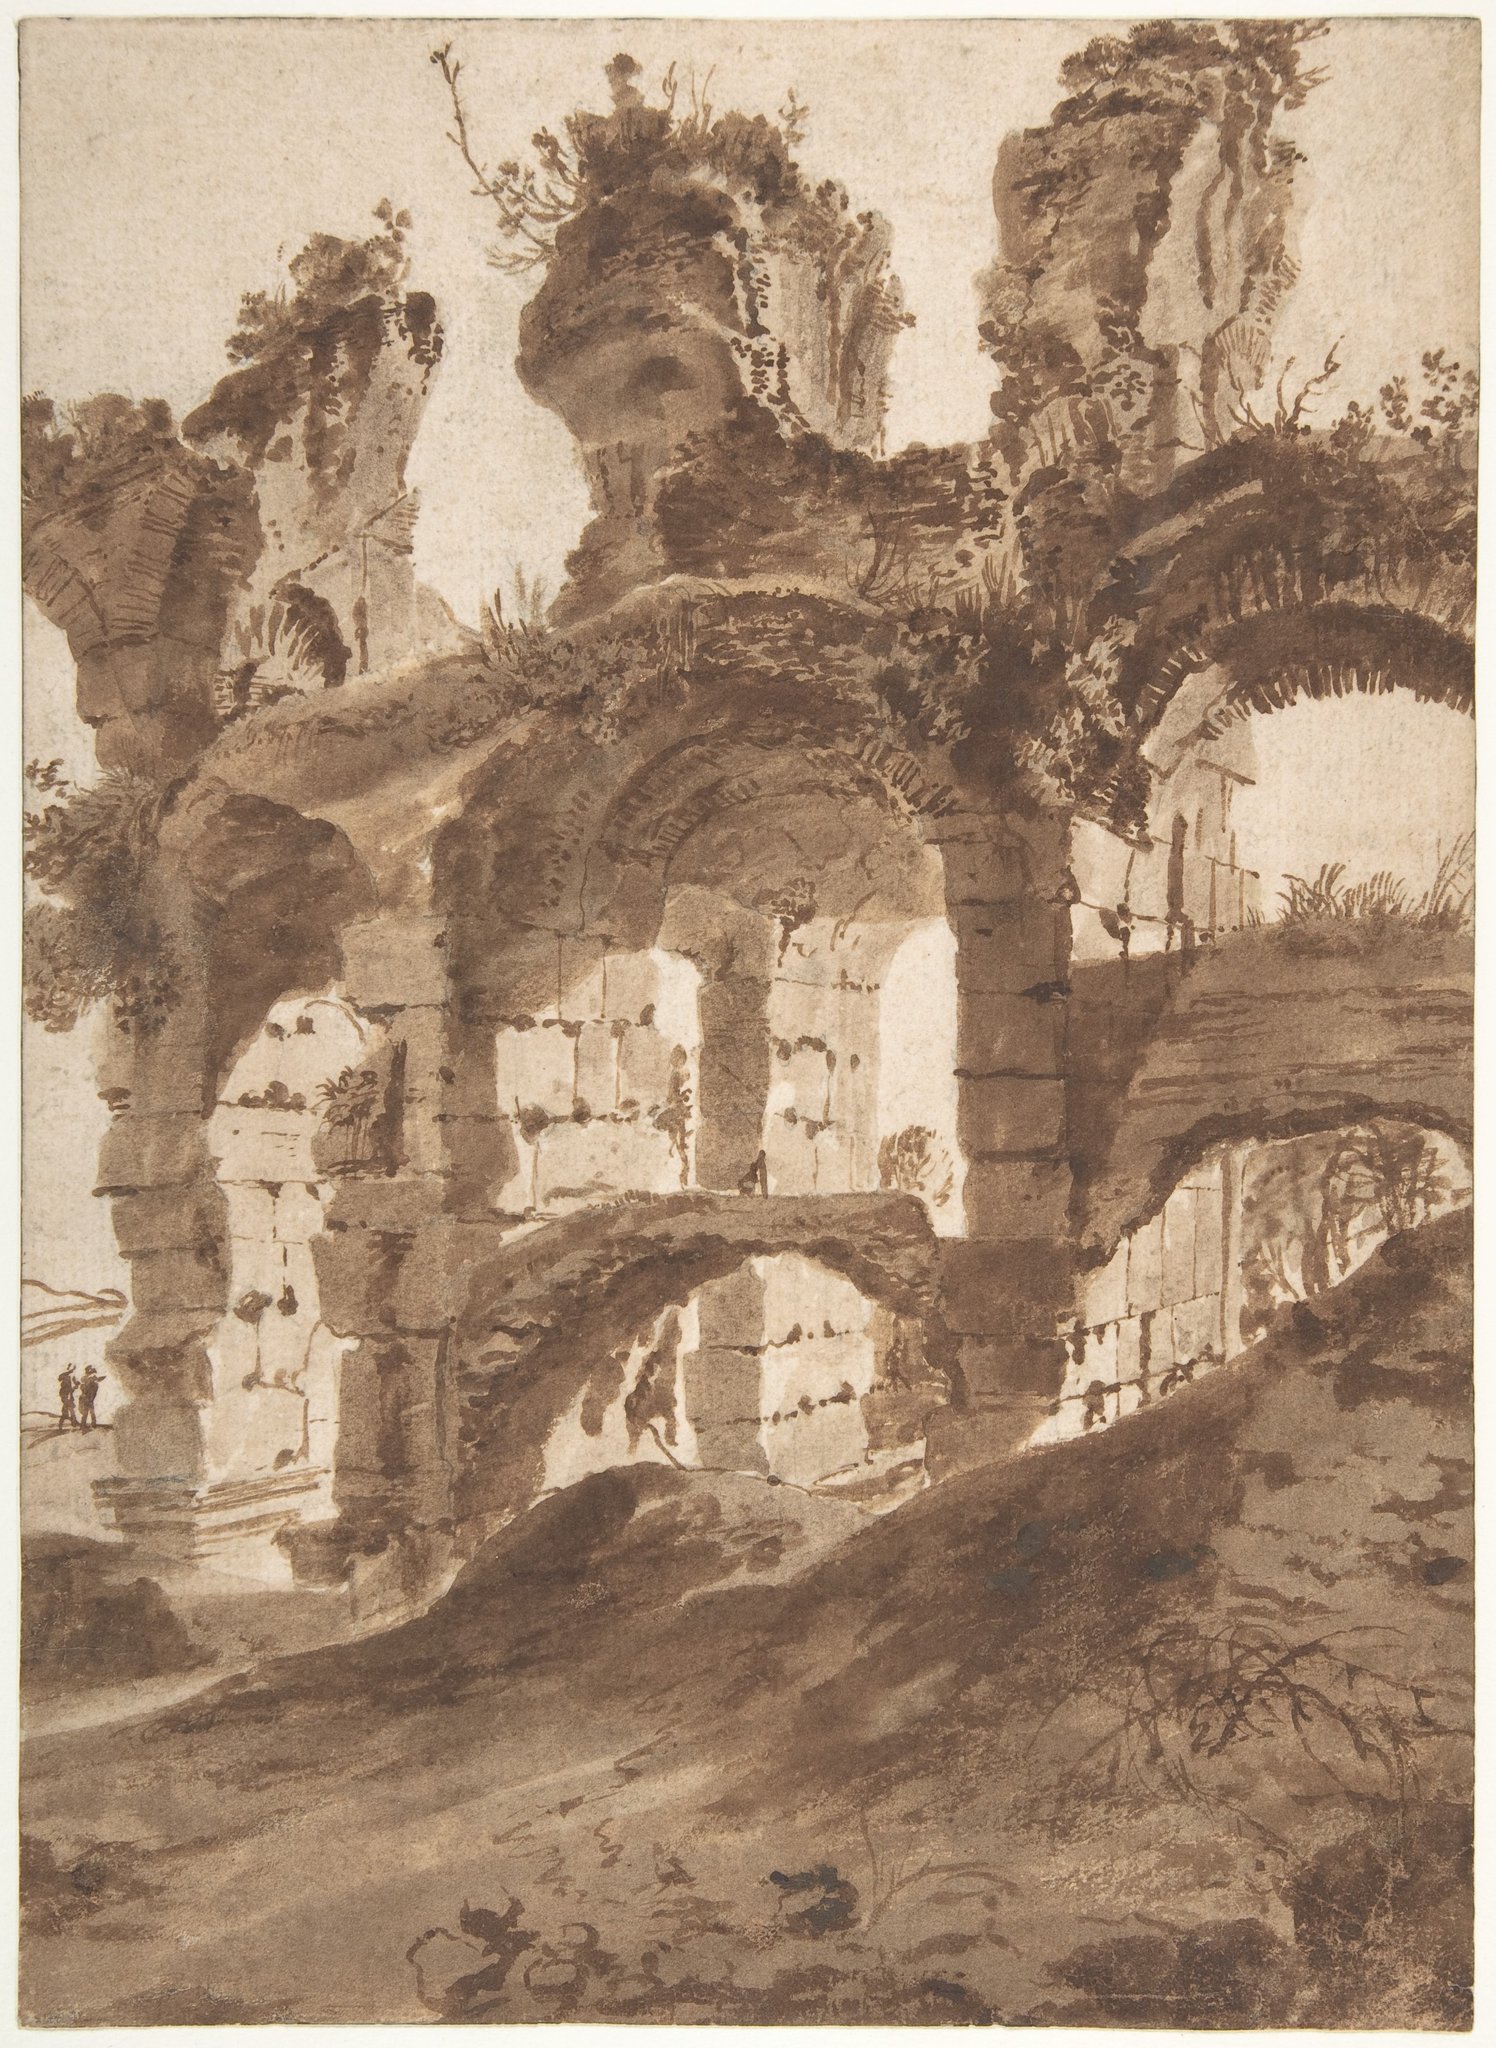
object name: drawing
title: Colosseum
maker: bartholomeus breenbergh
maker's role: artist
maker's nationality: dutch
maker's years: 1598-1657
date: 1601-1633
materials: ink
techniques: brush, pen, wash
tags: arches,ruins